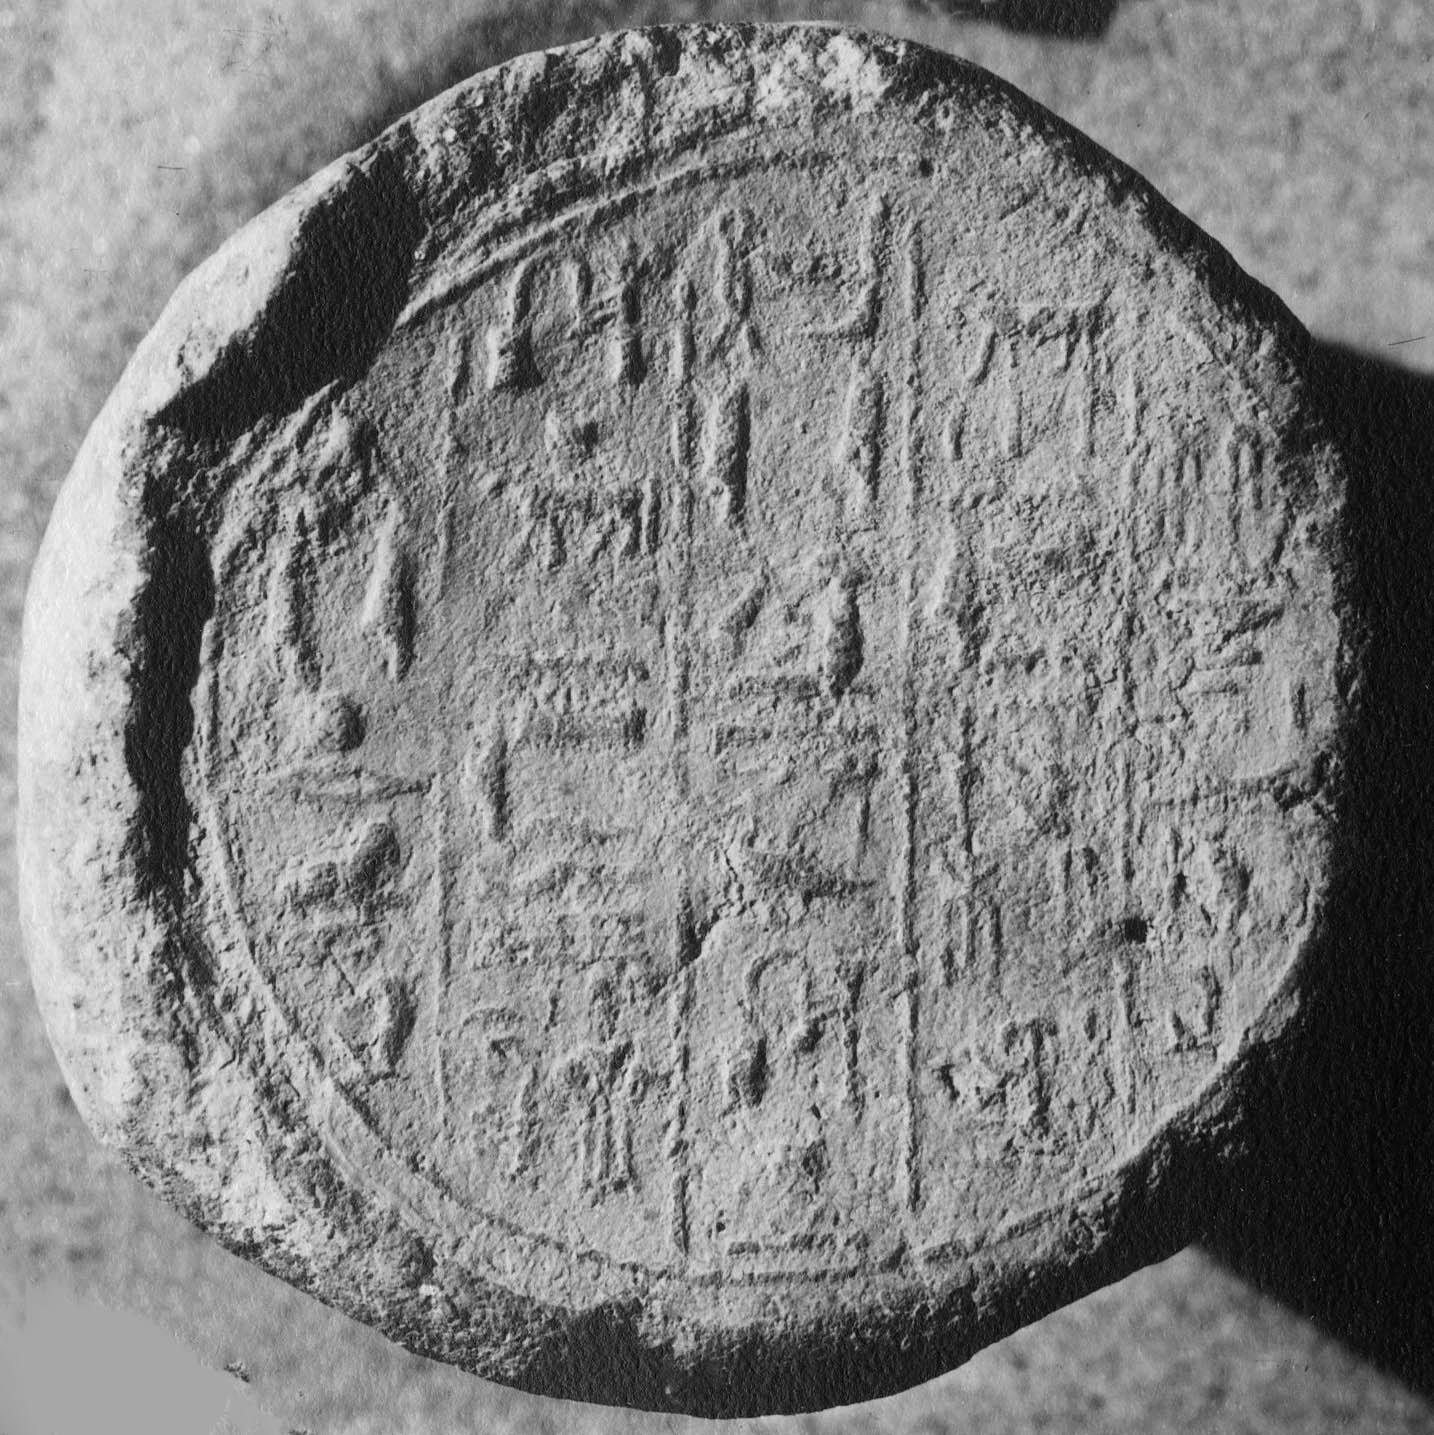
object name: cone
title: Funerary Cone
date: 1550-1295 BCE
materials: pottery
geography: egypt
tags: hieroglyphs